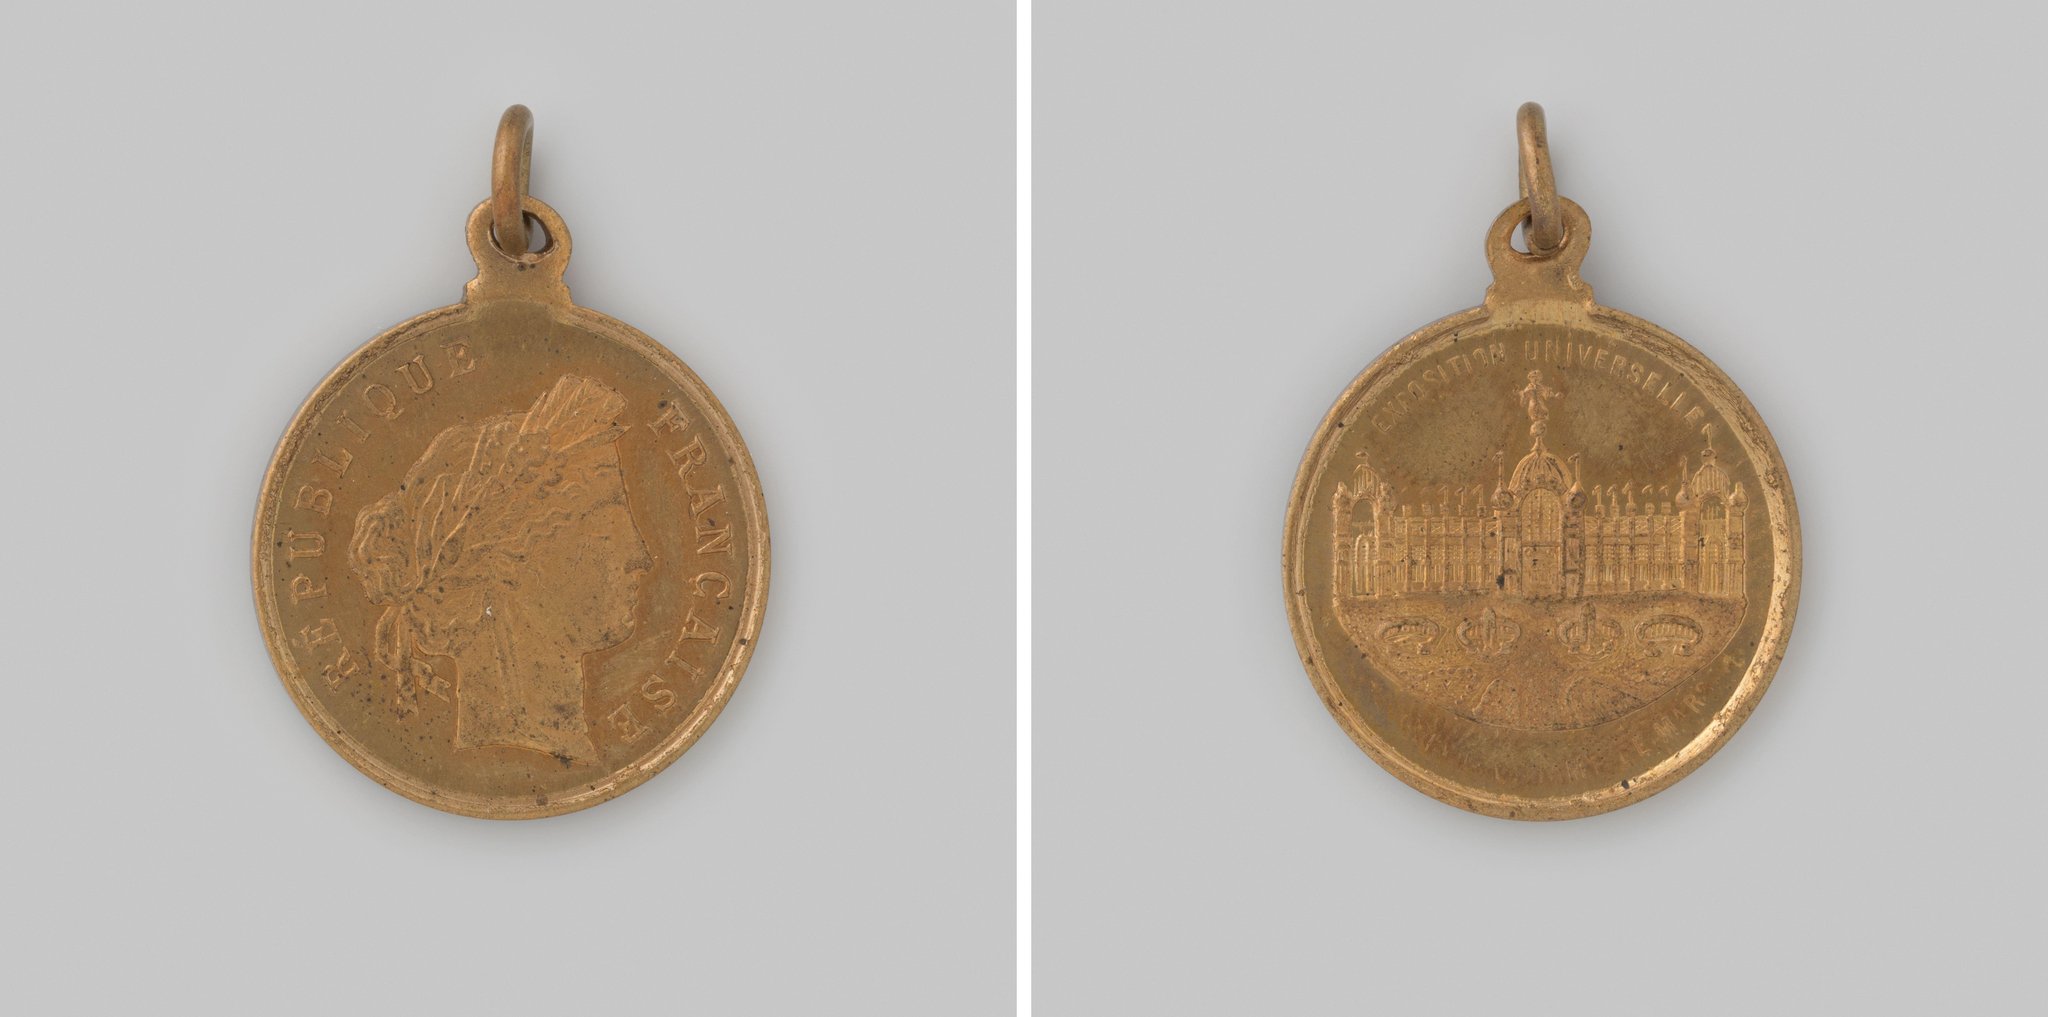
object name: history medal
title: Wereldtentoonstelling op de Champs de Mars te Parijs (1878)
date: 1878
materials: brass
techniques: striking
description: Vergulde penning met ring en draagoog, op de voorzijde het portret van Ceres naar rechts met omschrift, op de keerzijde het tentoonstellingsgebouw aan het Champs de Mars, met omschrift